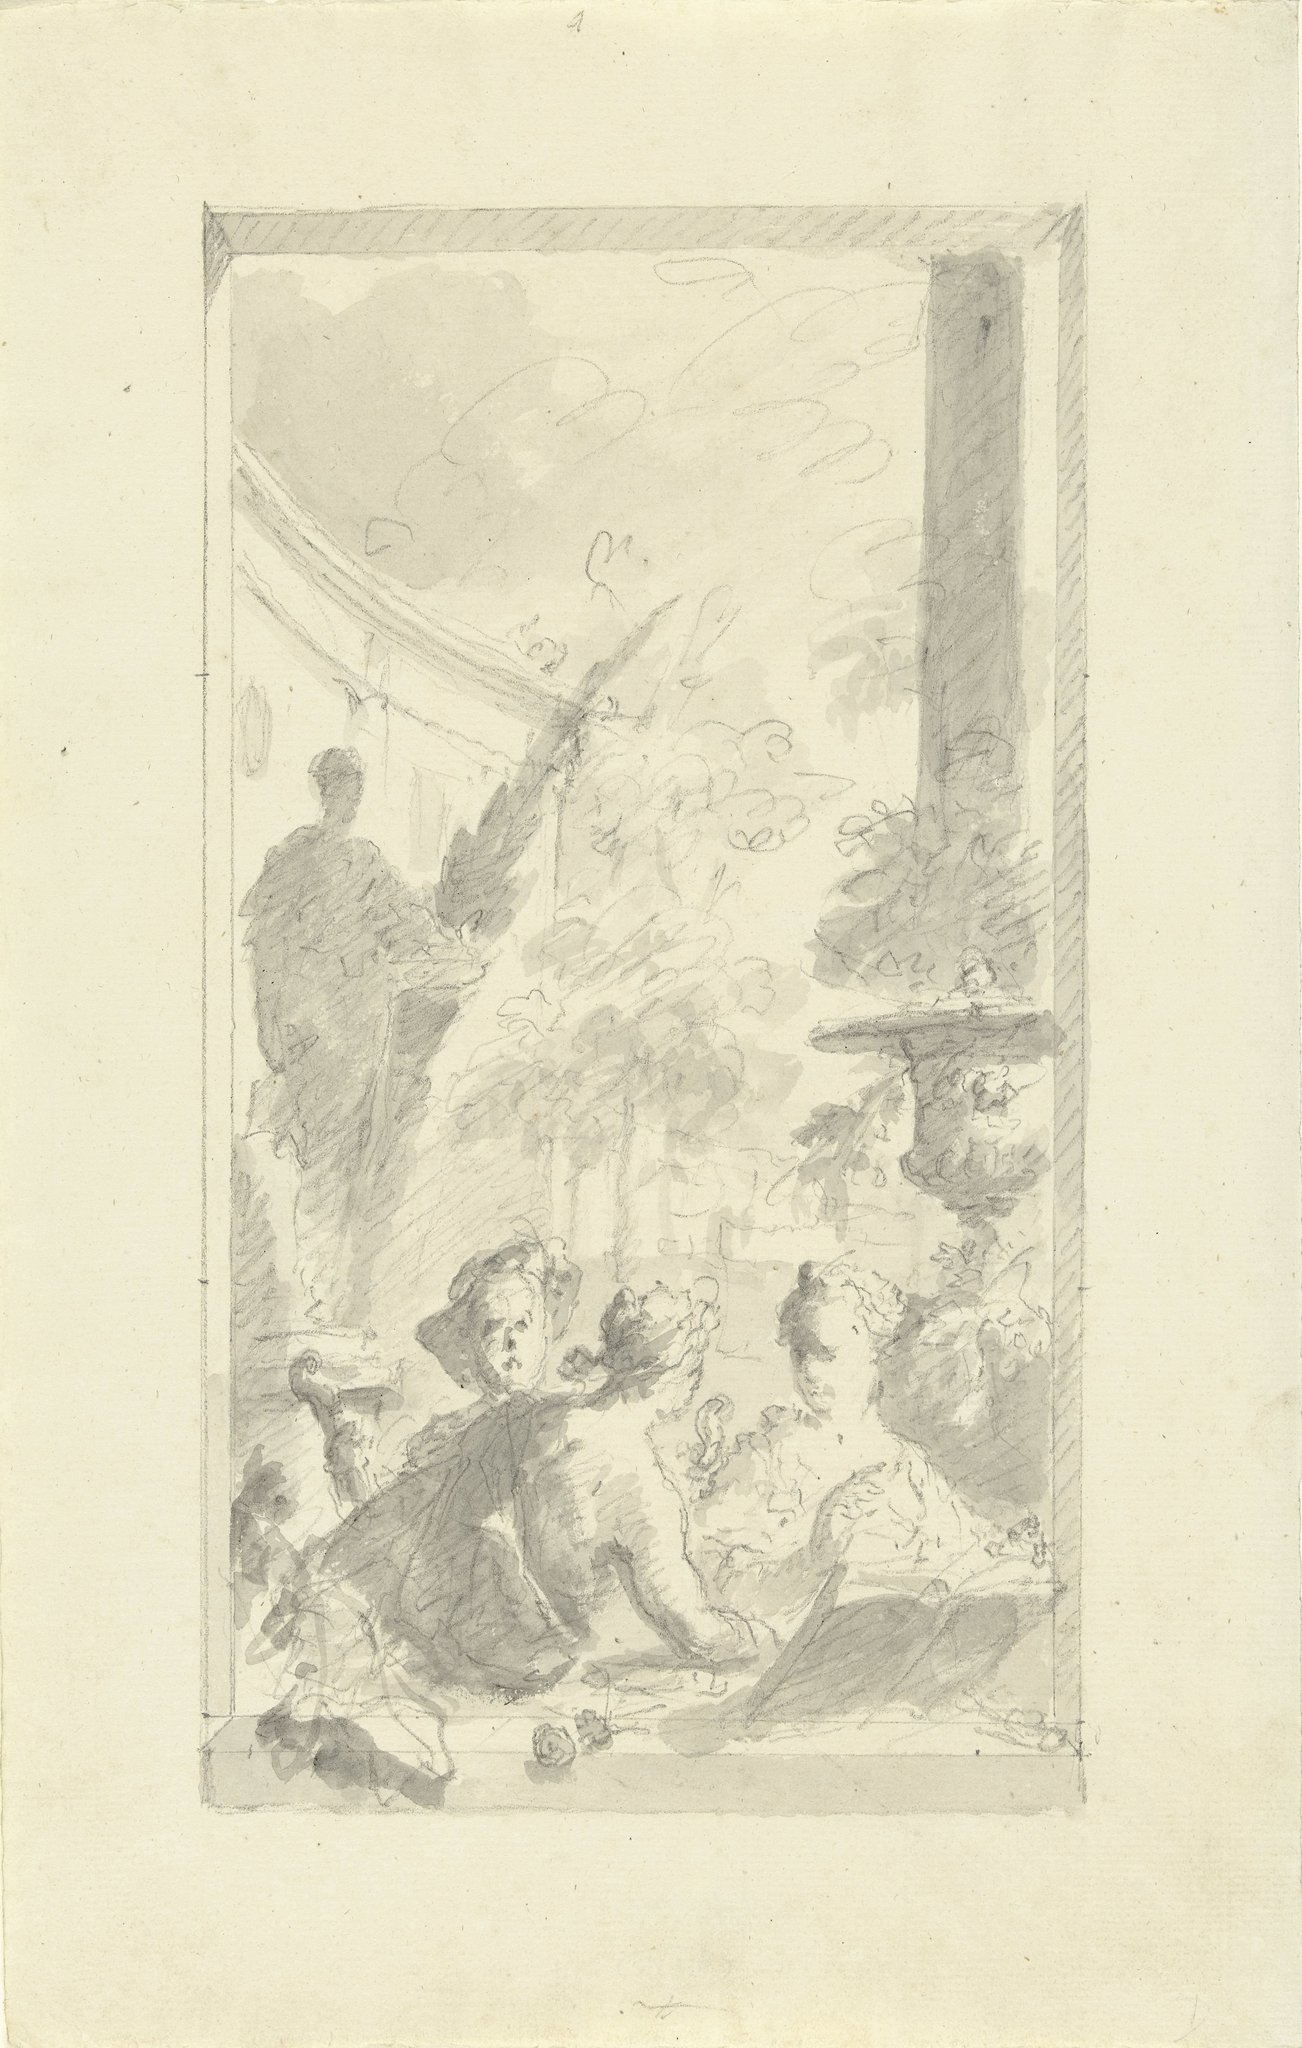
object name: design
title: Ontwerp voor een zaalstuk: musicerend gezelschap in tuin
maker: dionys van nijmegen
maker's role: draughtsman, painter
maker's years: 1705-1798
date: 1756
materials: paper, pencil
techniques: brush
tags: garden, more than one musician with instrument - cc - 'concert champêtre'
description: Ontwerp voor een schildering. Ontwerptekening gemaakt in opdracht van Mr. Huijbert van Rijckevorsel (1709-1770) voor een vertrek in diens huis aan de Catharinastraat 18 in Breda.